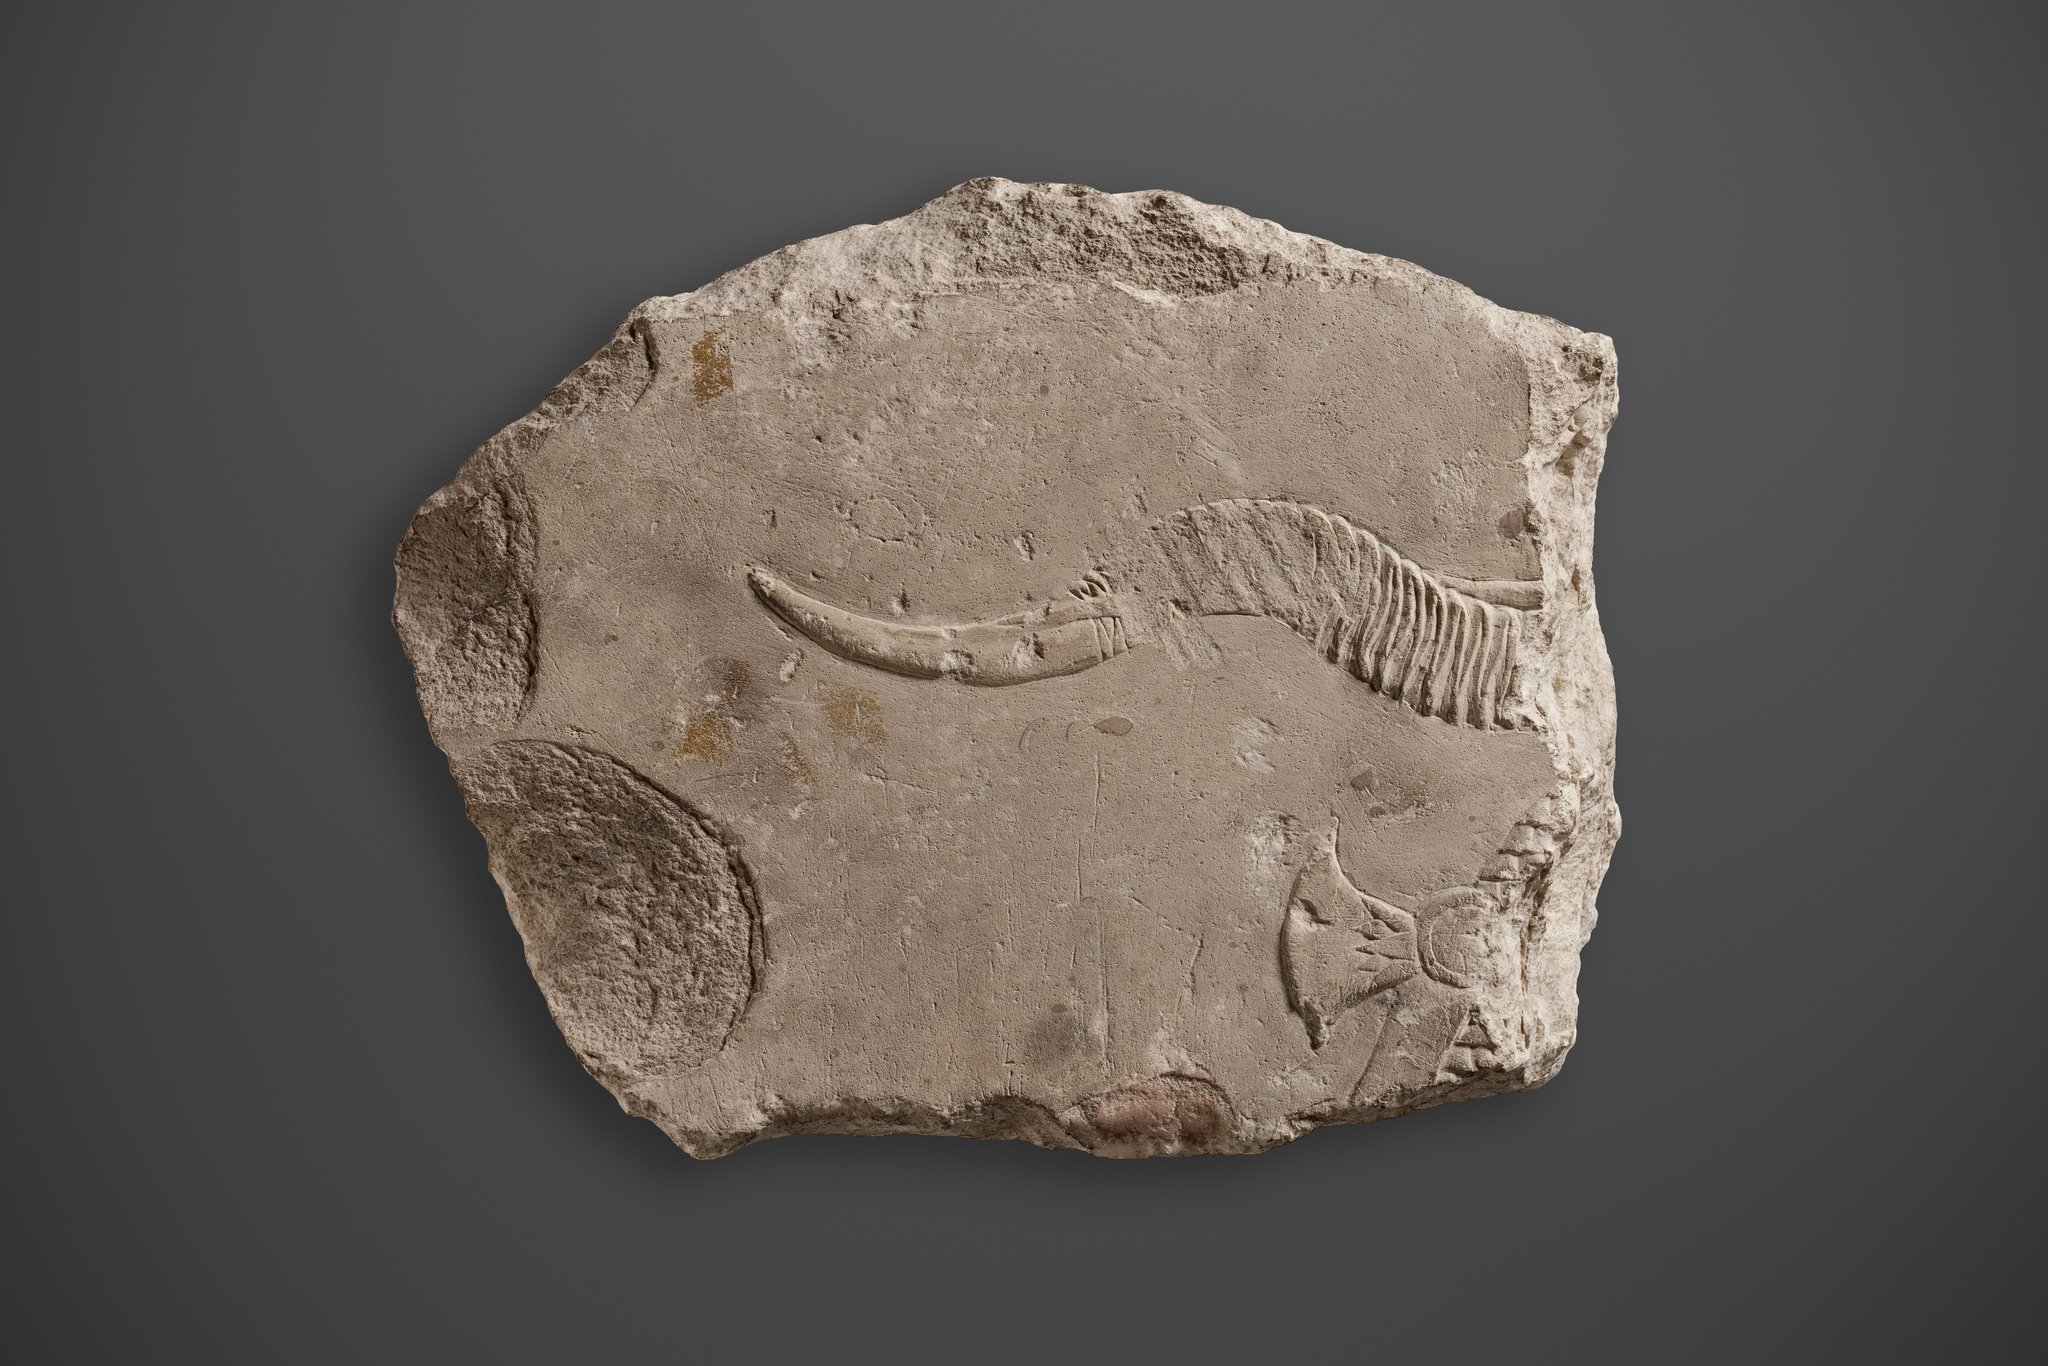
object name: relief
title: Block of Relief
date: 1961-1917 BCE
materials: limestone, paint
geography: egypt